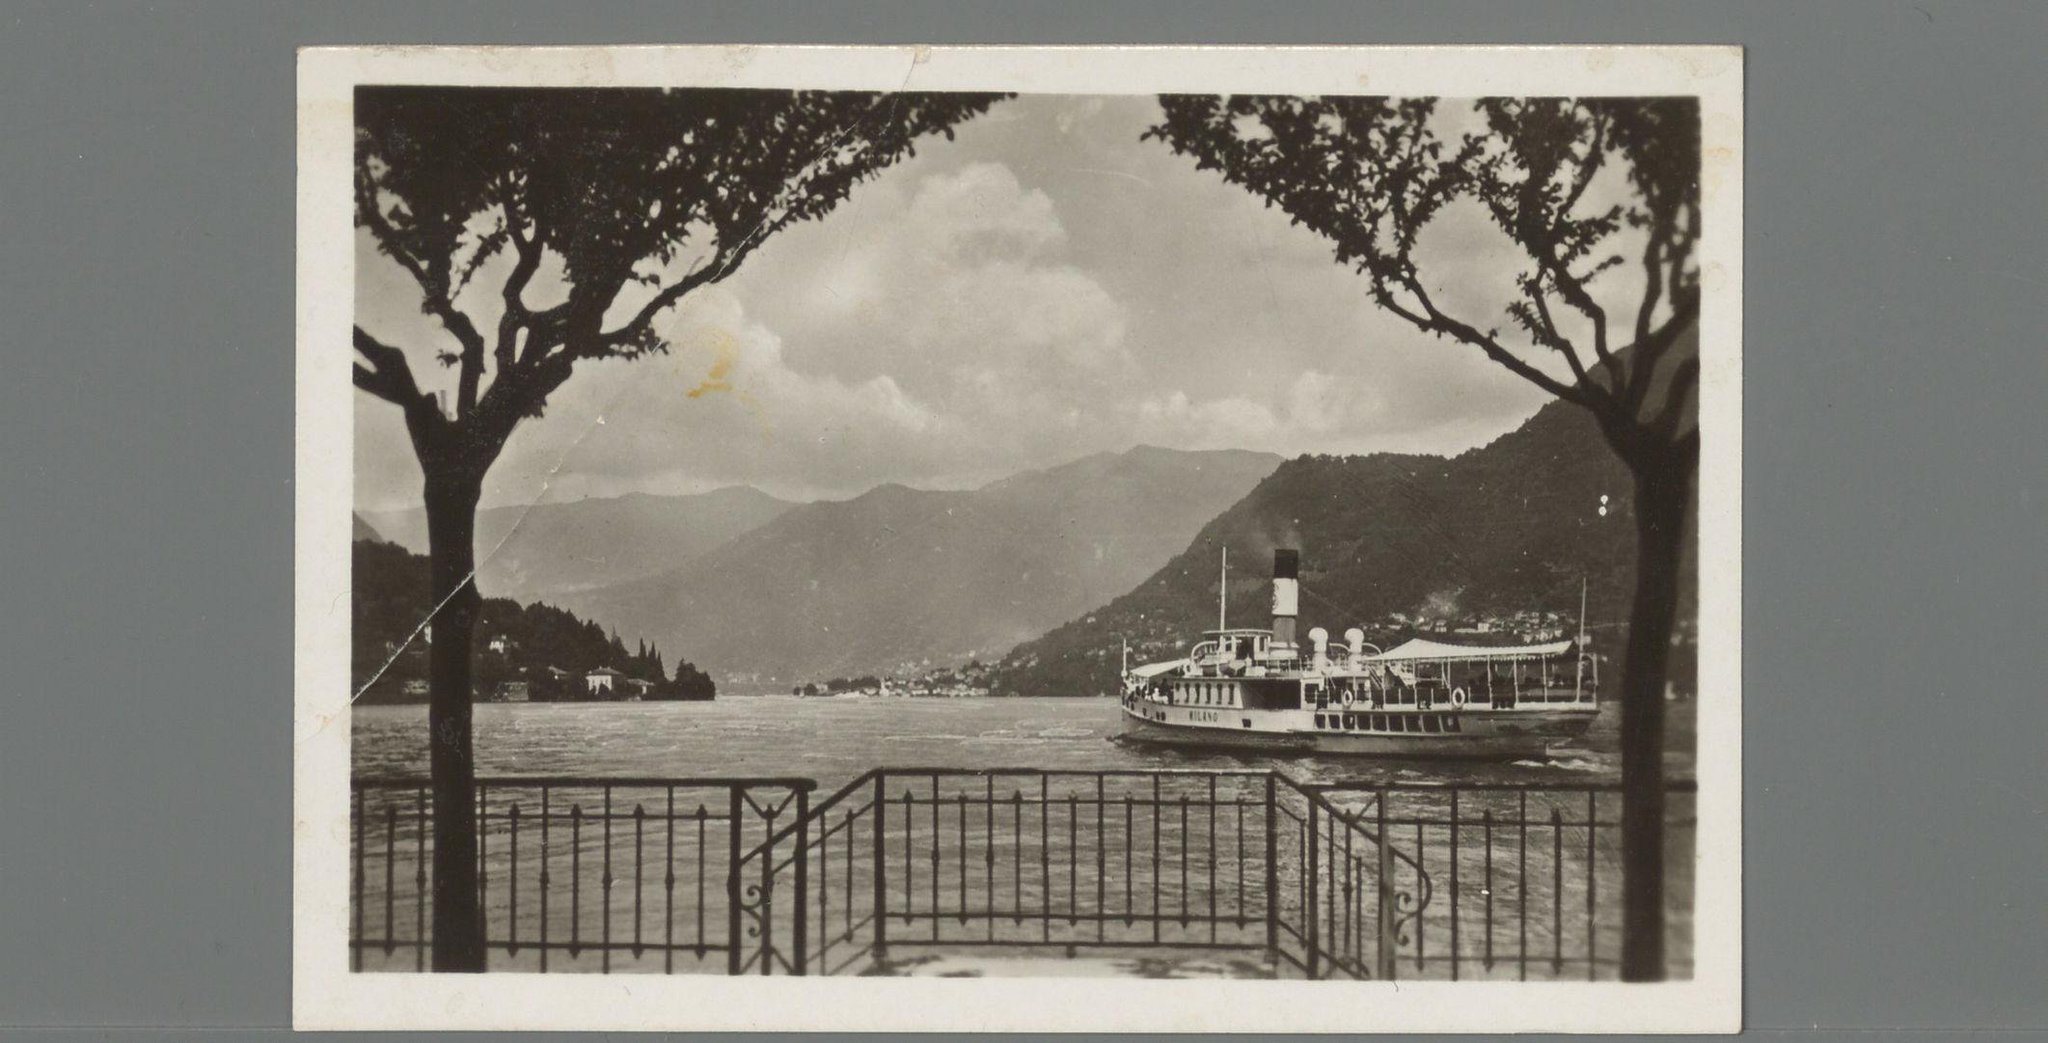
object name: photograph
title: Lago di Como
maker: Anonymous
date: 1910-1930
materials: paper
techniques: gelatin silver print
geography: lake como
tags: ships (in general), lake, mountains